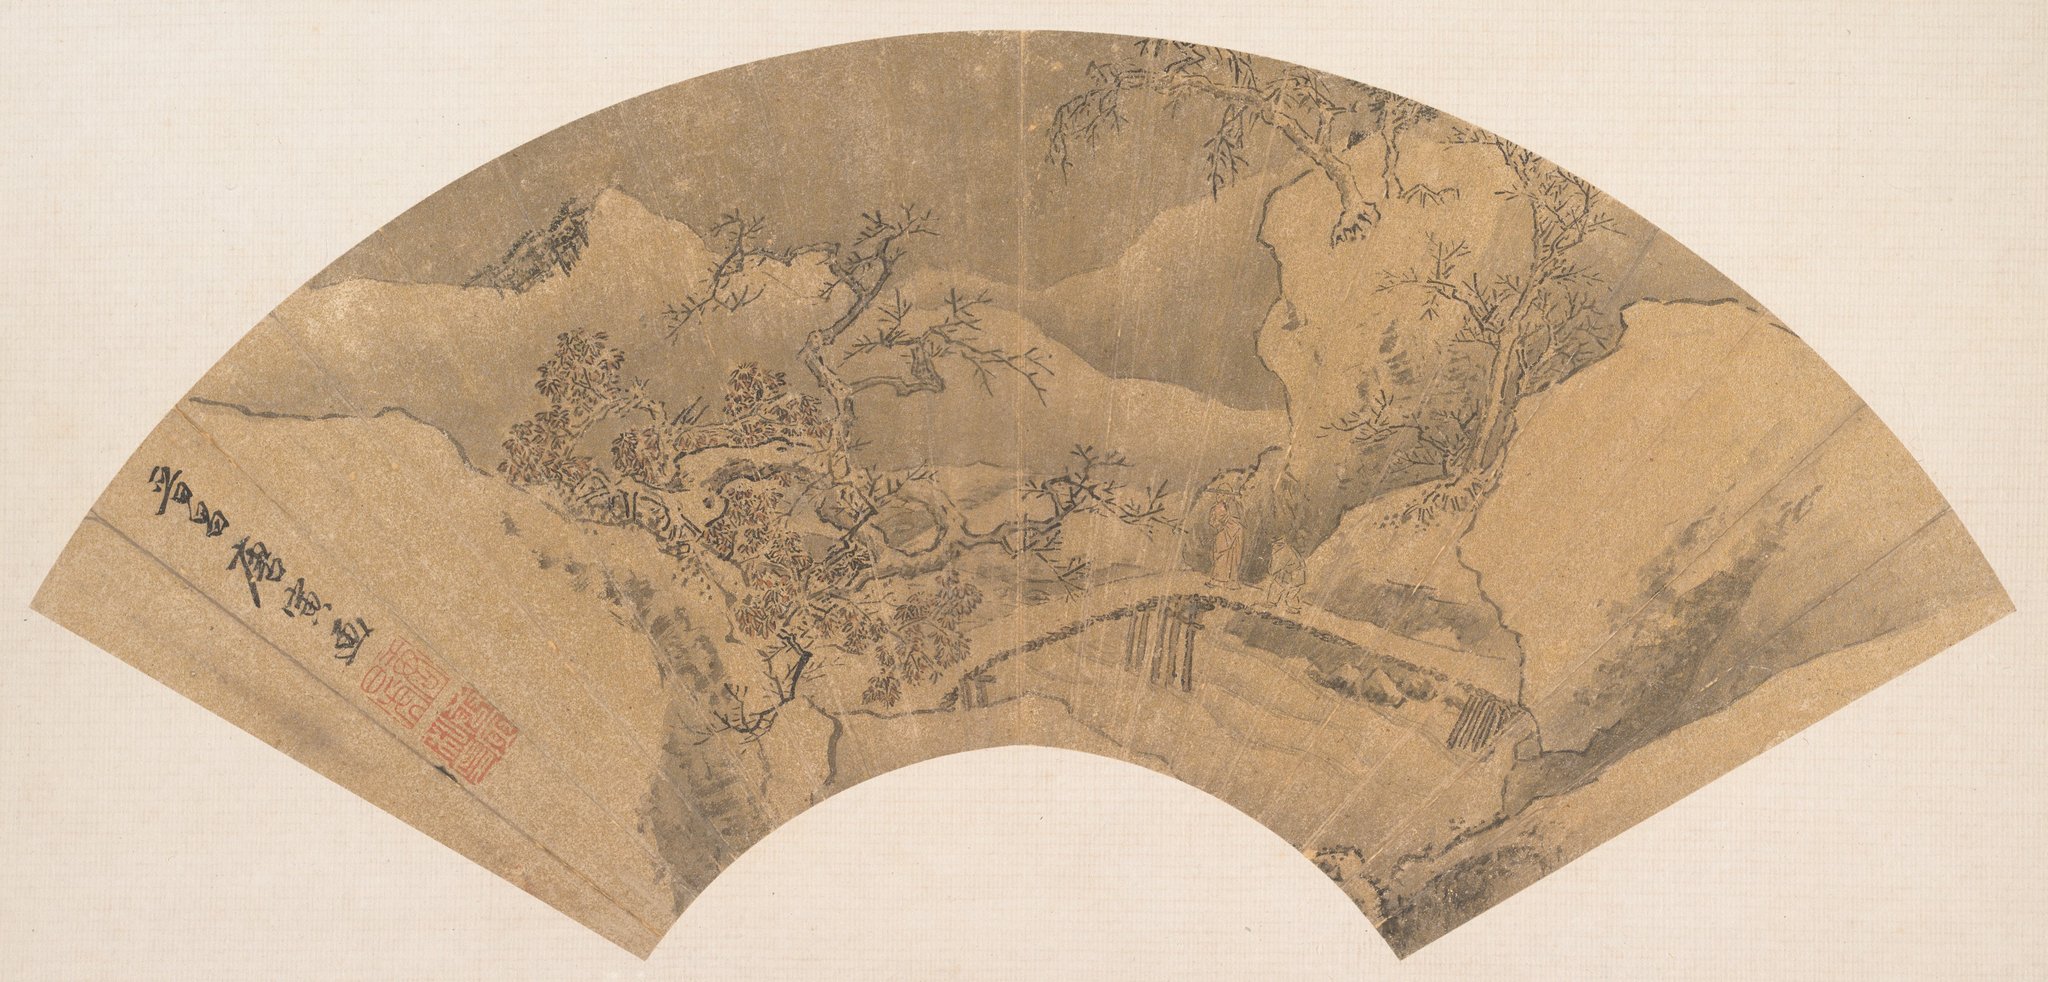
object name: folding fan mounted a an album leaf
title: Winter Landscape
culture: chinese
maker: unidentified artist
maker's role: artist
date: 1368-1644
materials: gold, ink, paper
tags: mountains,landscapes,winter